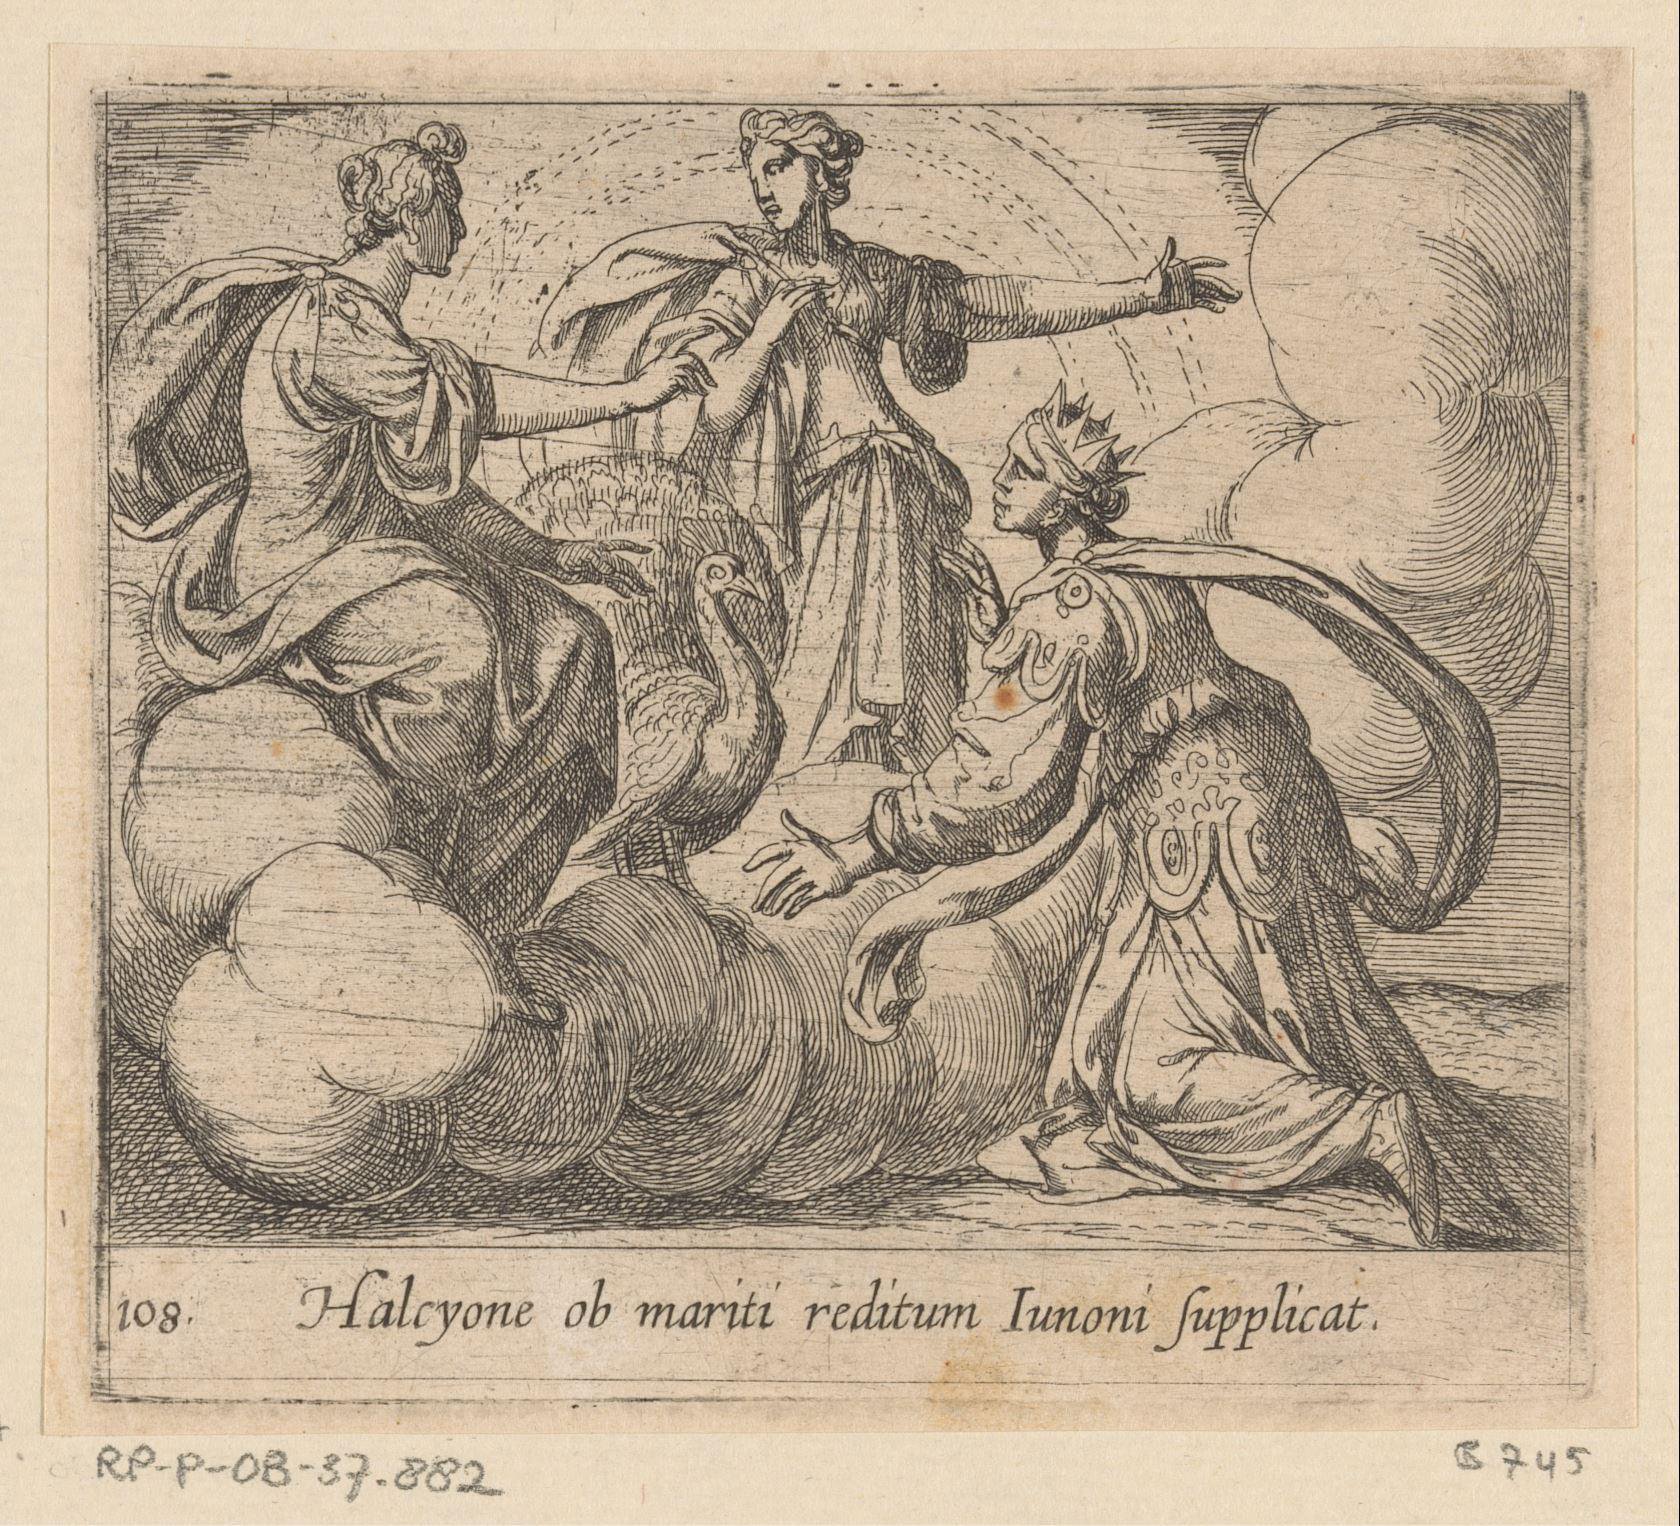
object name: print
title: Halcyone ob mariti reditum Iunoni supplicat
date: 1606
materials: paper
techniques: etching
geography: antwerp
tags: (story of) alcyone and ceyx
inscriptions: collector's mark: Lugt 240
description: Deze prent maakt deel uit van een reeks van 150 prenten (+ titelprent) met voorstellingen van de Metamorfosen van Ovidius.